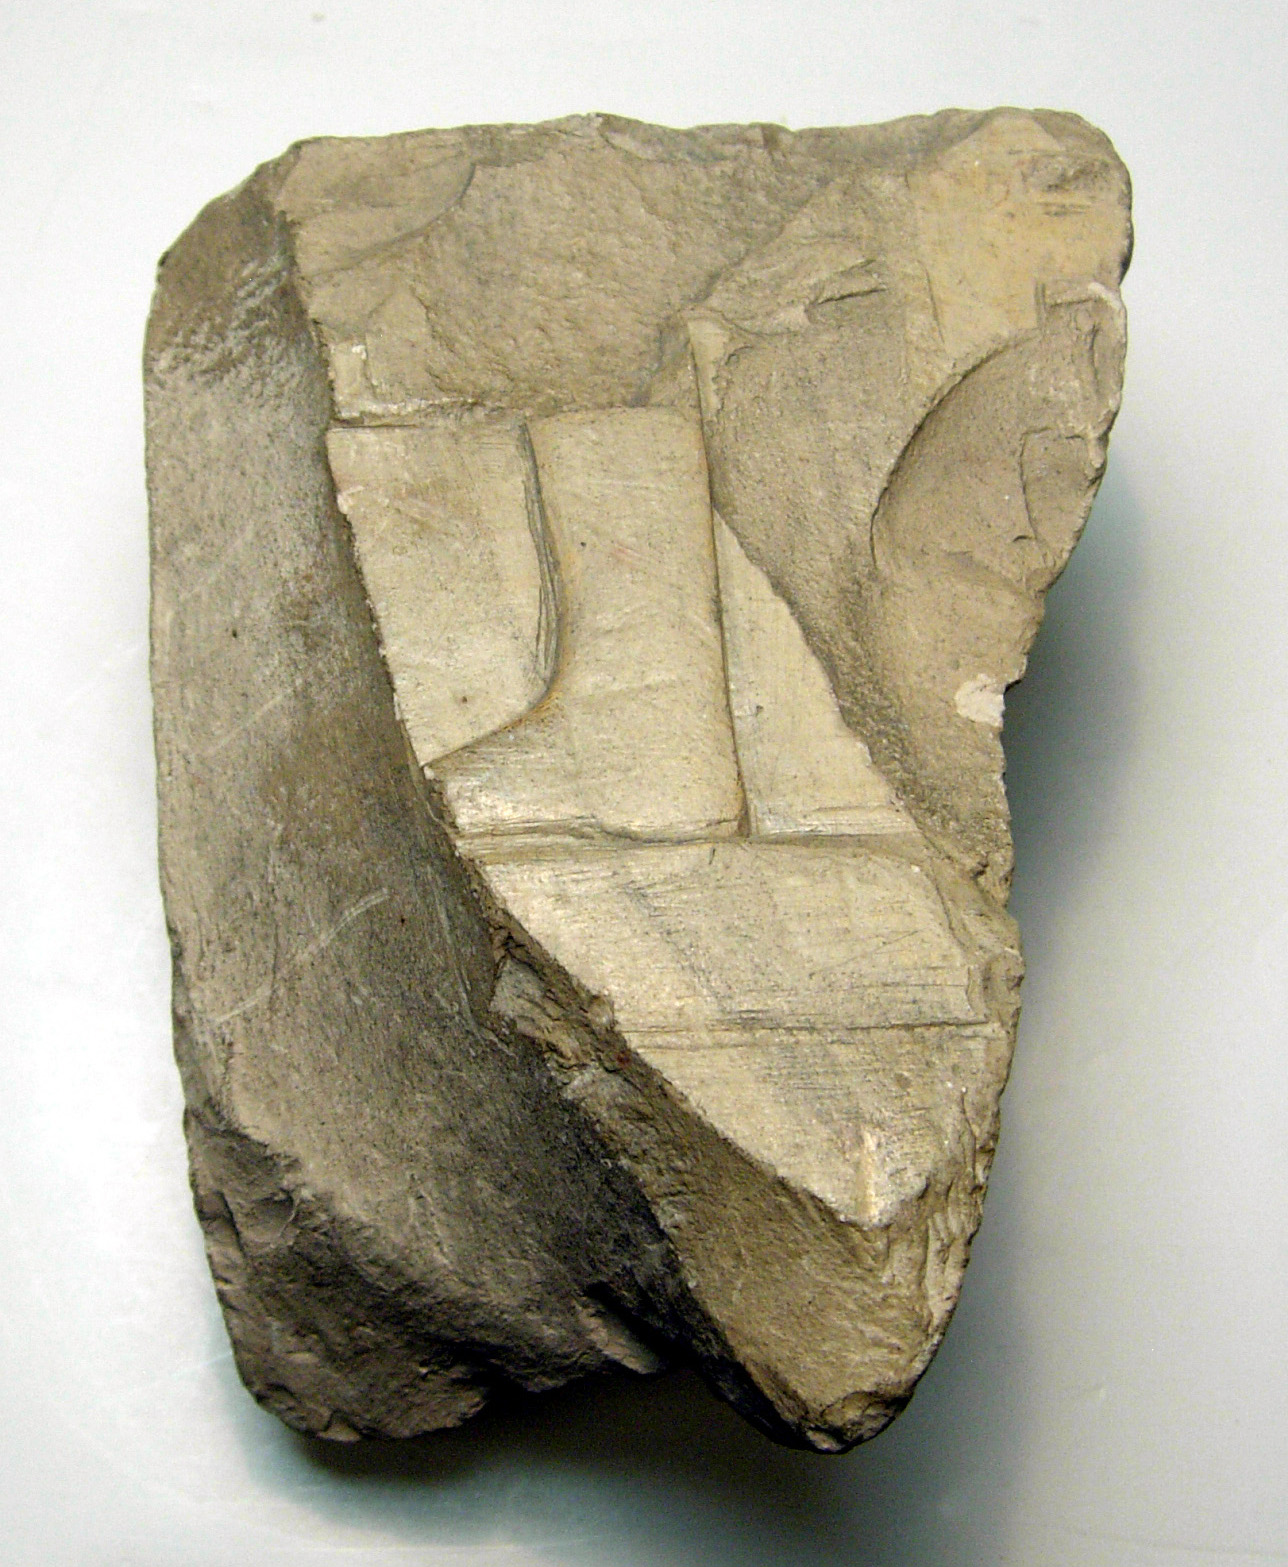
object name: relief, tomb of nespekashuty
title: Raised relief fragment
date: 664-610 BCE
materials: limestone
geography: egypt